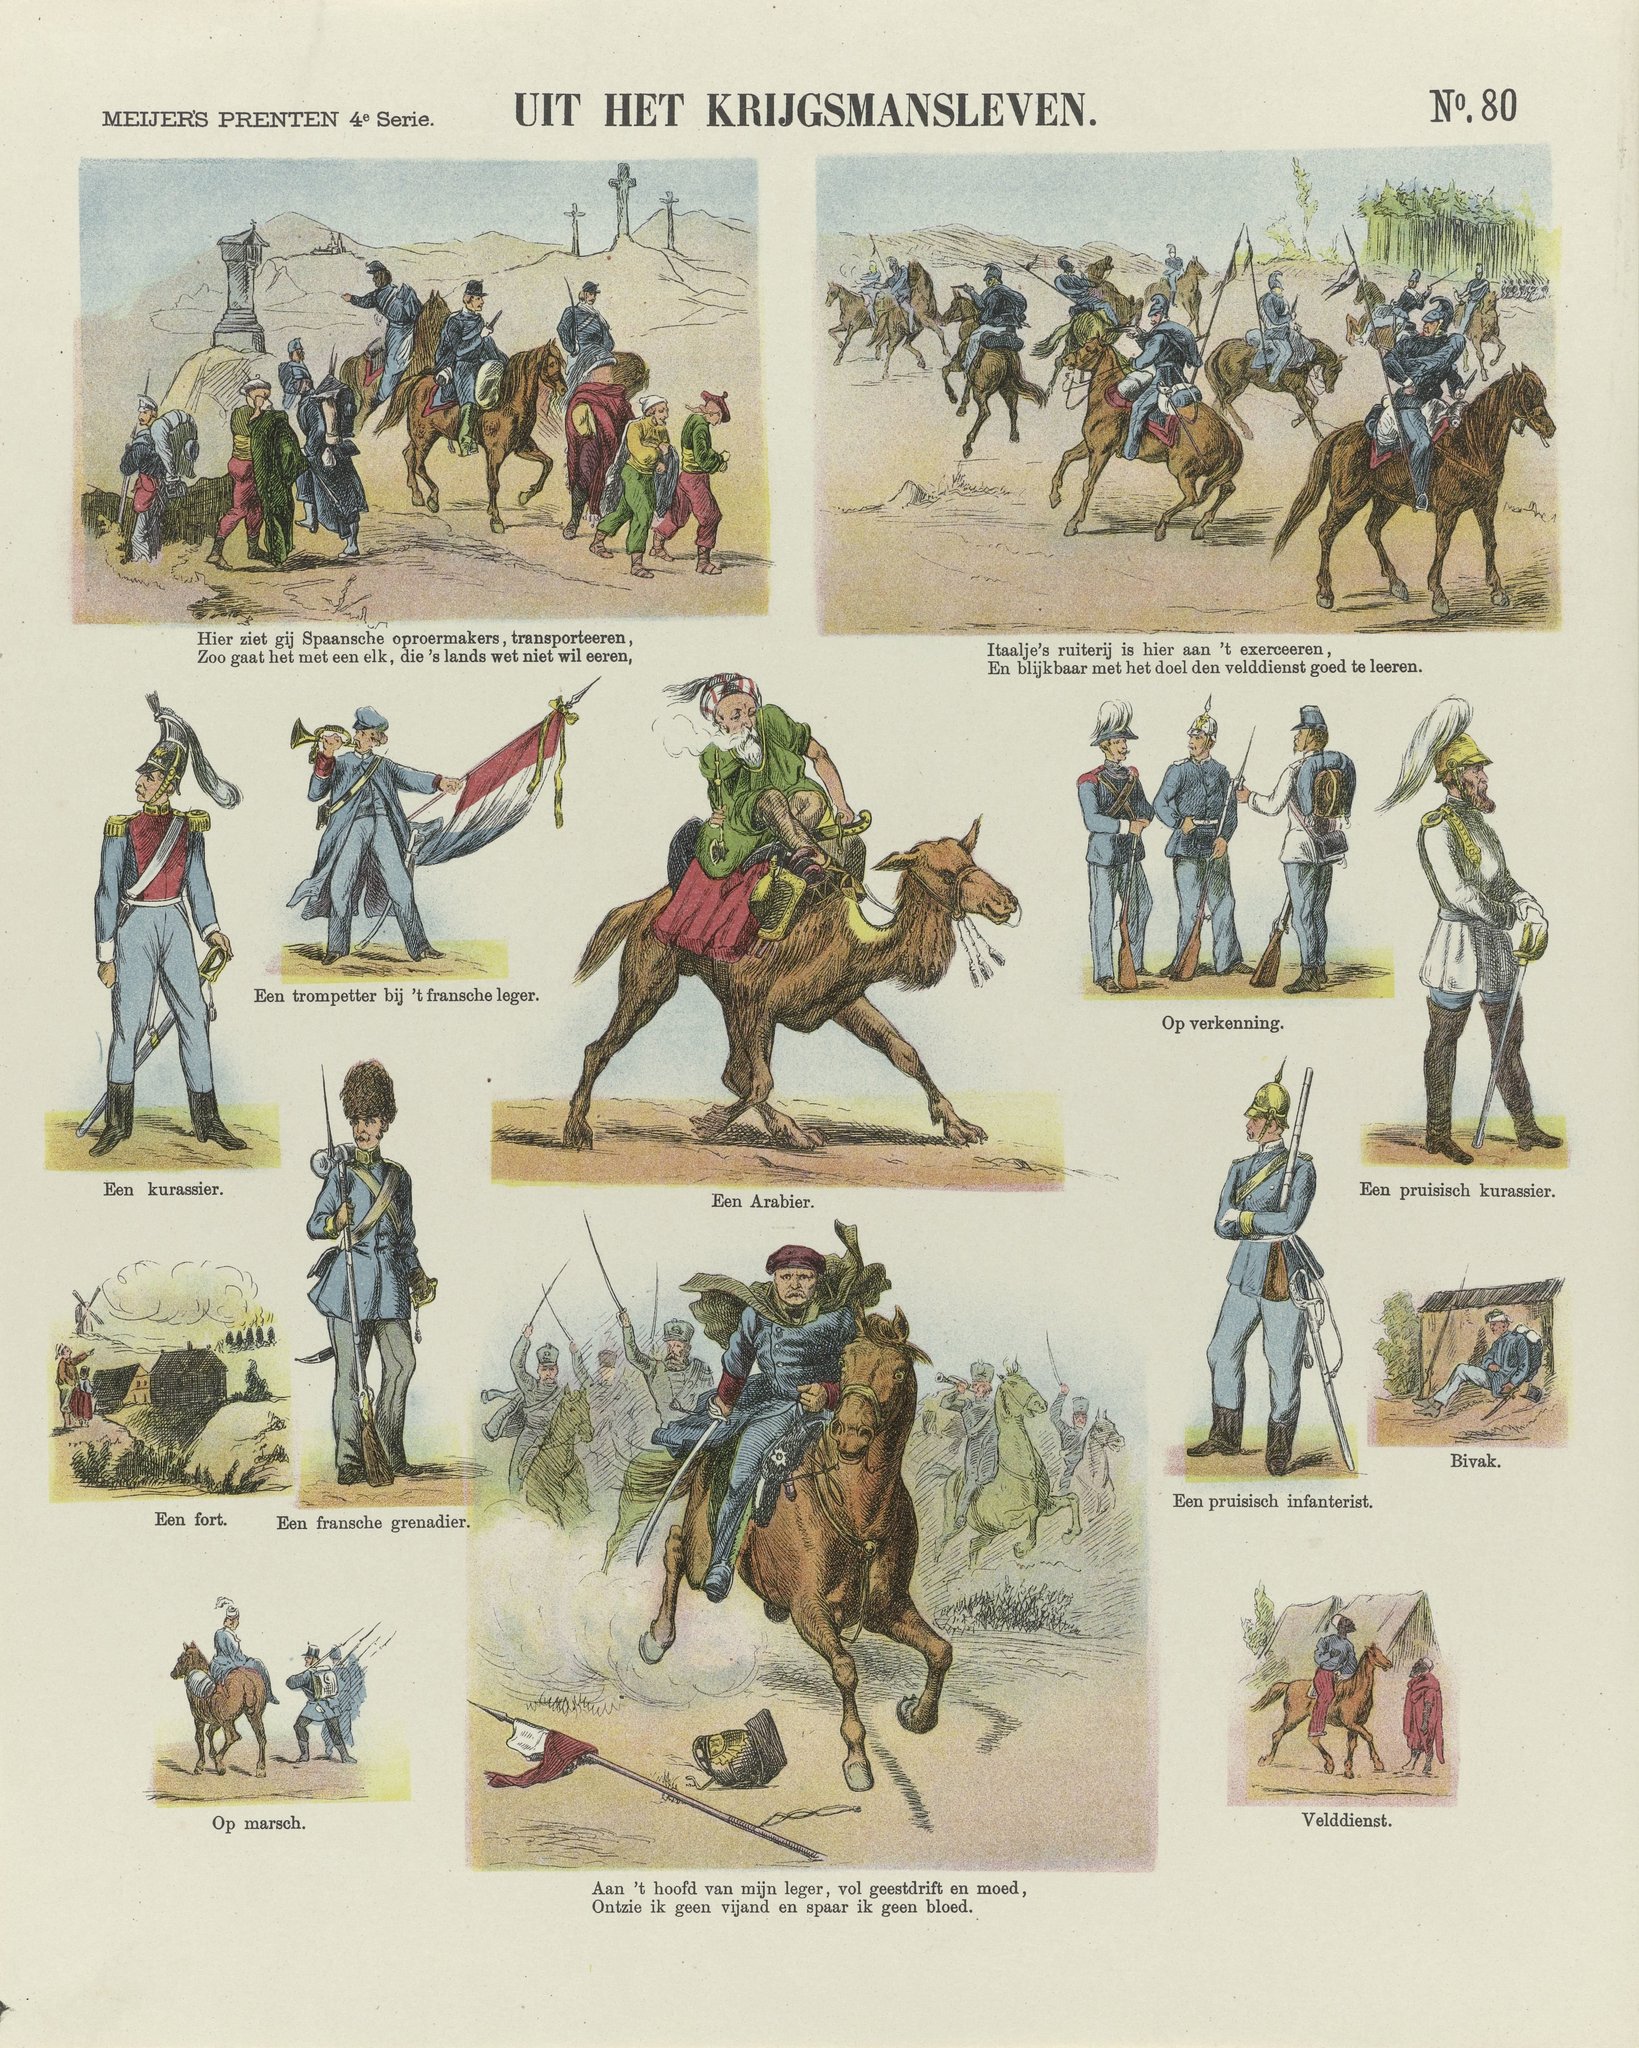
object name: popular print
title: Meijer's prenten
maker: Anonymous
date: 1881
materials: paper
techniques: lithograph, letterpress printing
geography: amsterdam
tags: the soldier; the soldier's life, (military) uniforms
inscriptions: collector's mark: Lugt 2760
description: Blad met 14 voorstellingen over soldaten, onder anderen soldaten uit verschillende landen en in verschillende uniformen, de ruiterij, een legerkamp en een gewonde soldaat. Onder elke afbeelding een onderschrift. Genummerd rechtsboven: No. 80.